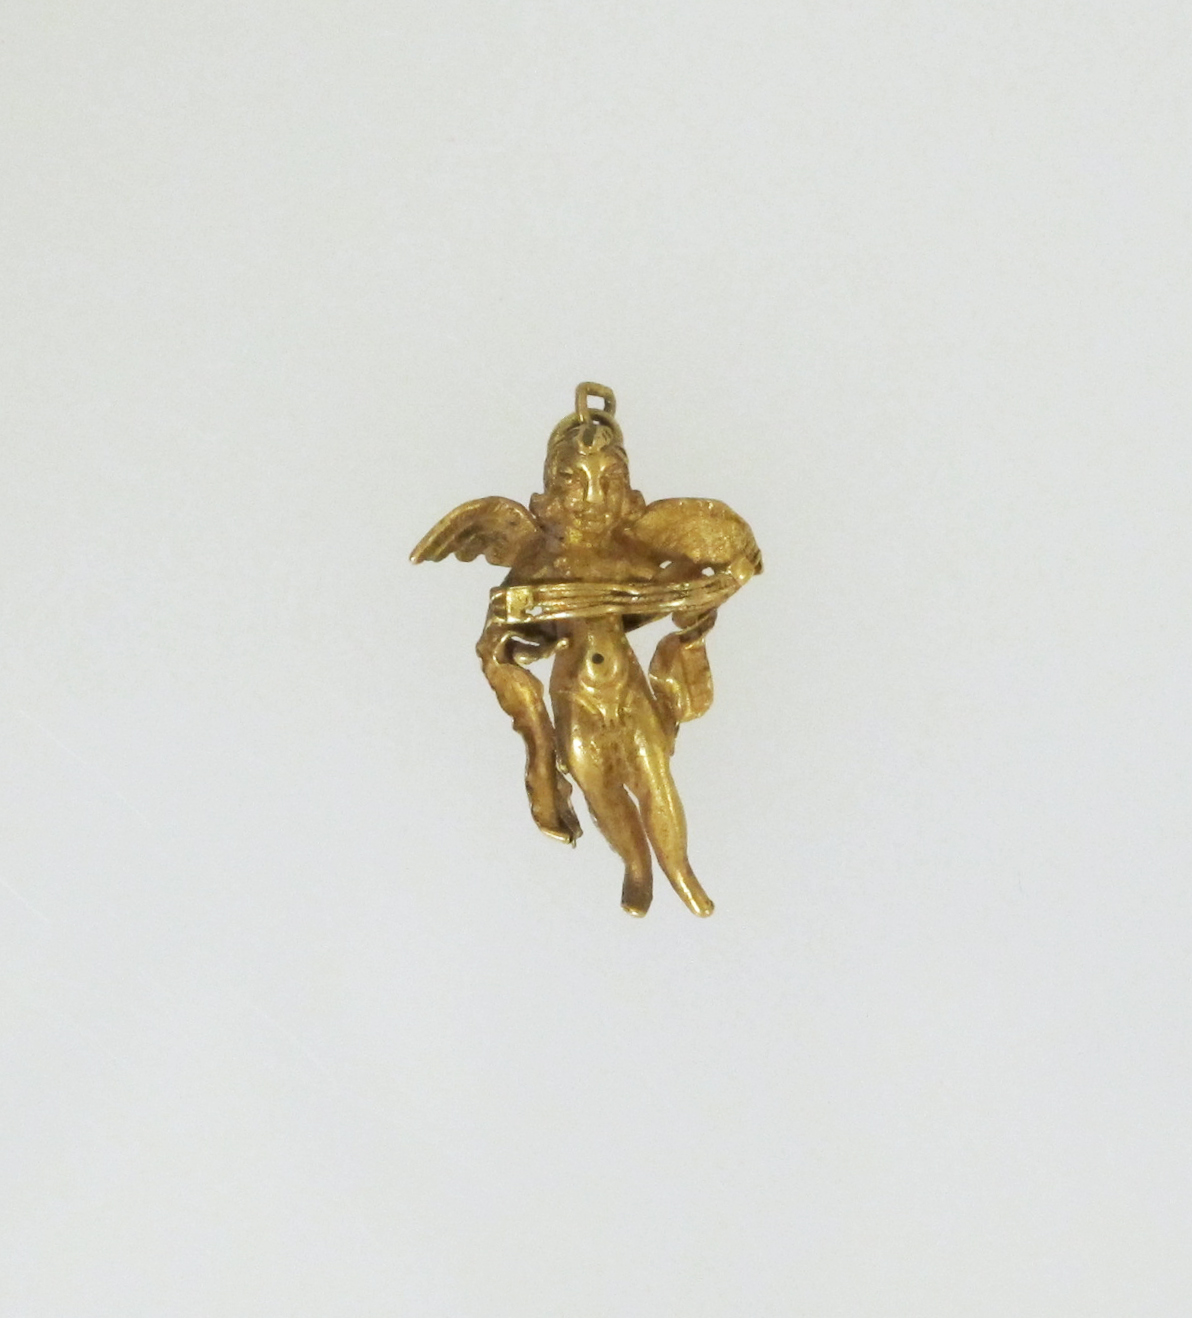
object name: pendant with eros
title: Pendant in the form of Eros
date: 400-201 BCE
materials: gold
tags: eros